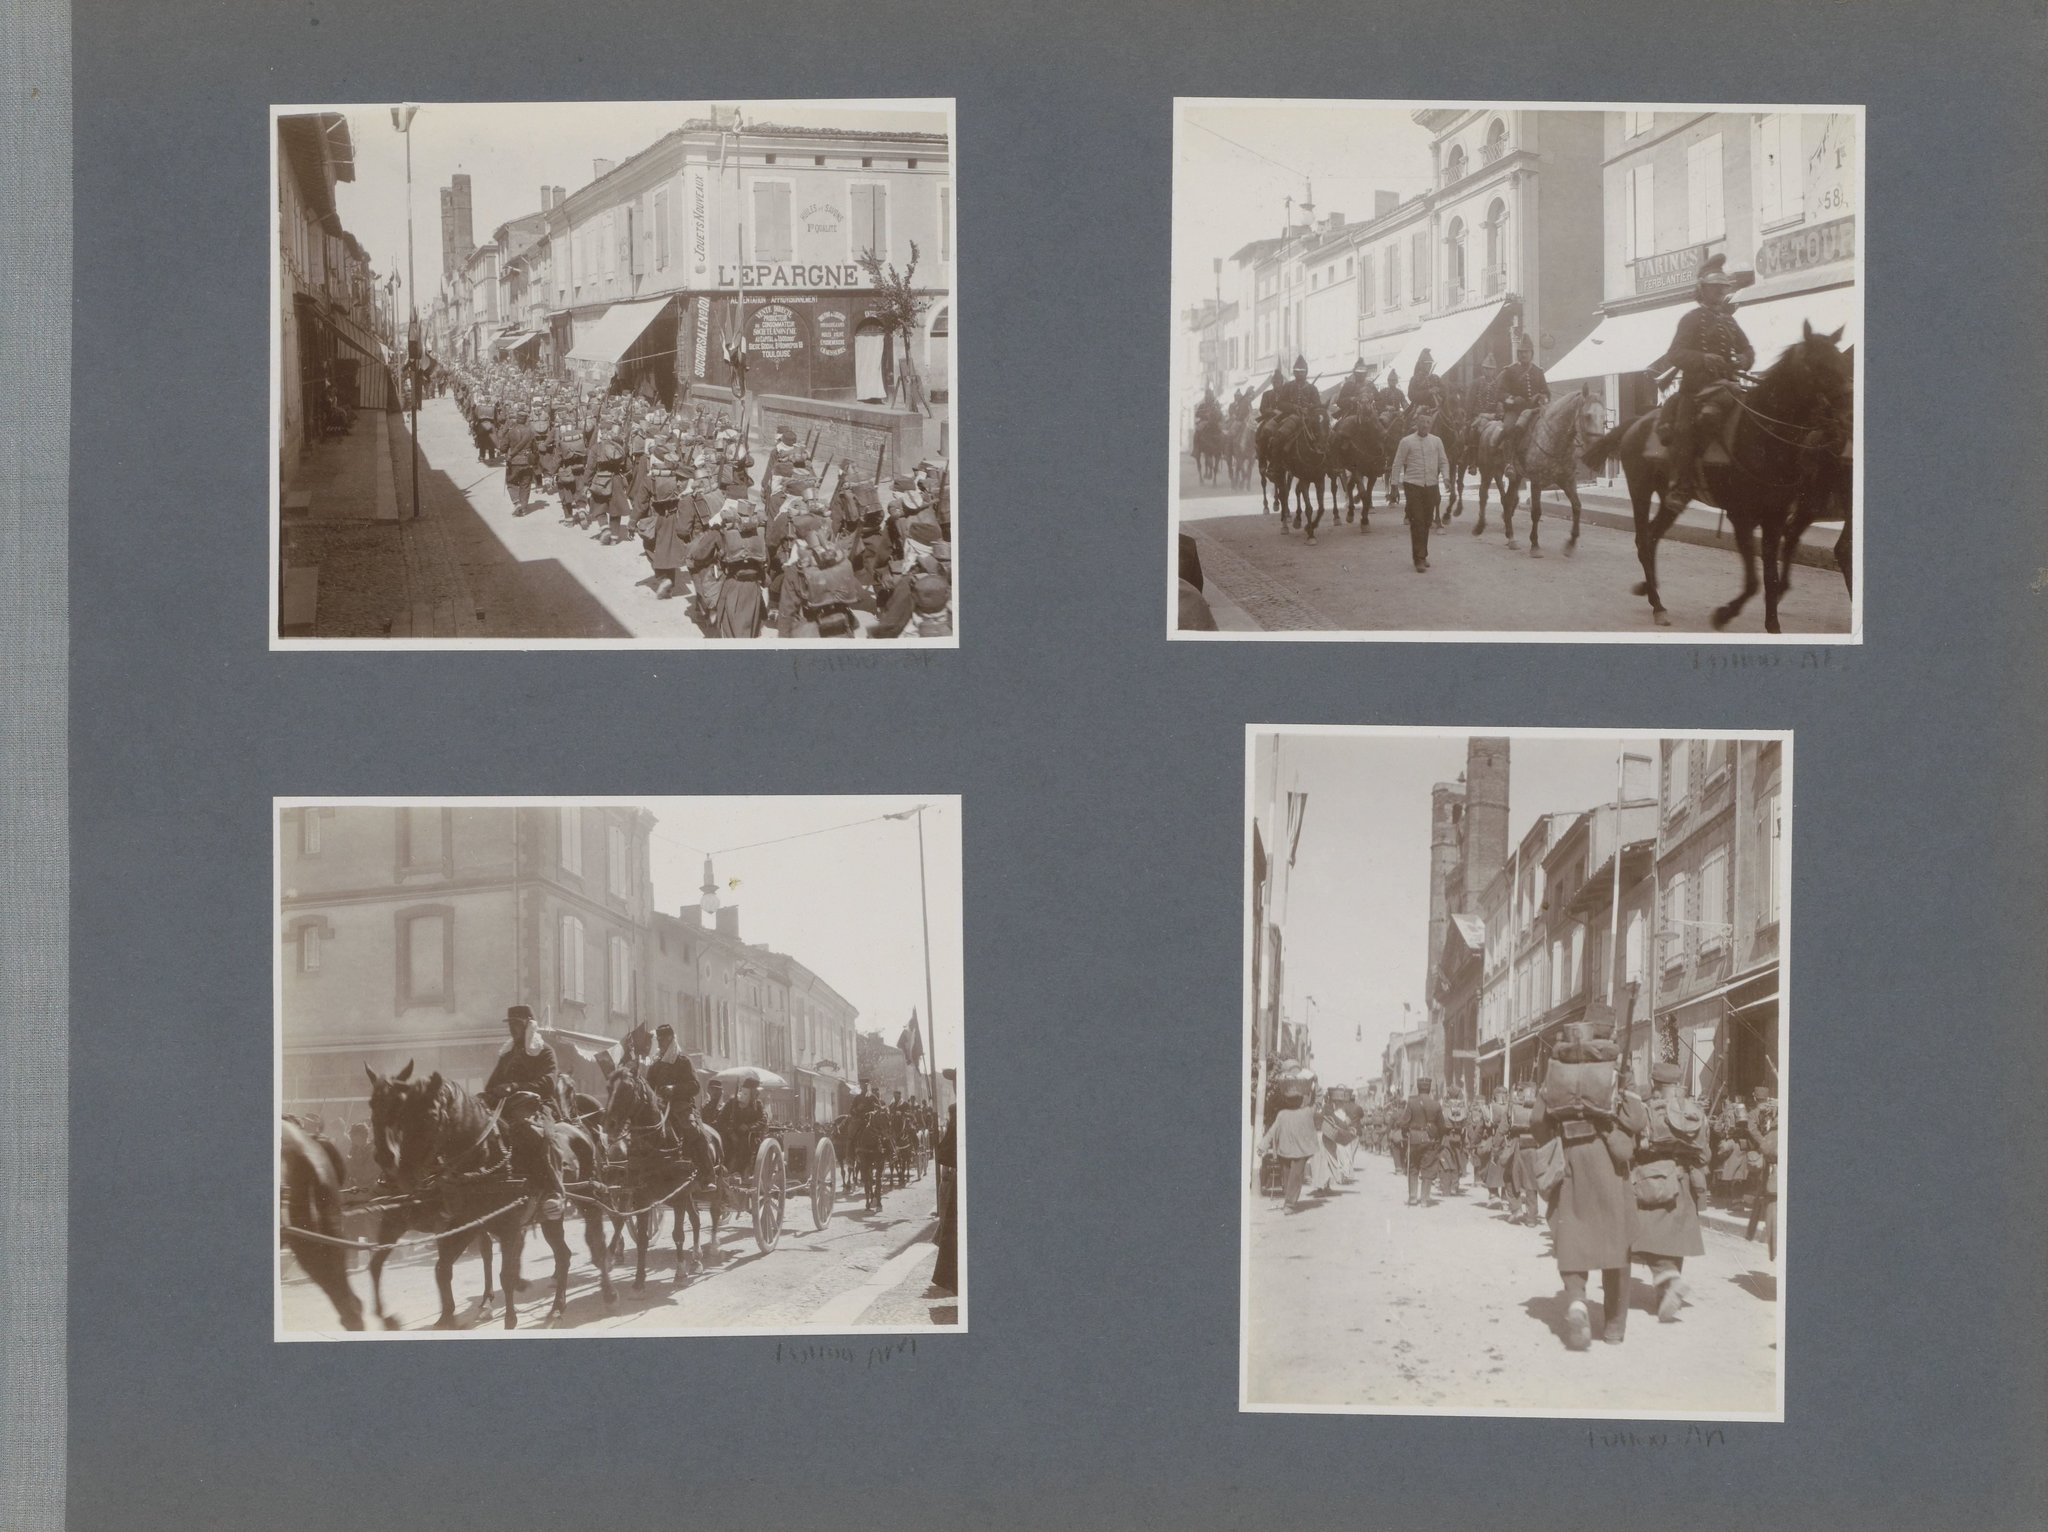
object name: photograph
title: Intocht van cavalerie in een stad in Frankrijk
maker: Anonymous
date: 1902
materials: paper, photographic support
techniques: daylight paper print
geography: france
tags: land forces (+ cavalry, horsemen), marching away (troops), france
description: Onderdeel van Fotoalbum van een legeroefening in Zuidwest-Frankrijk in 1902.